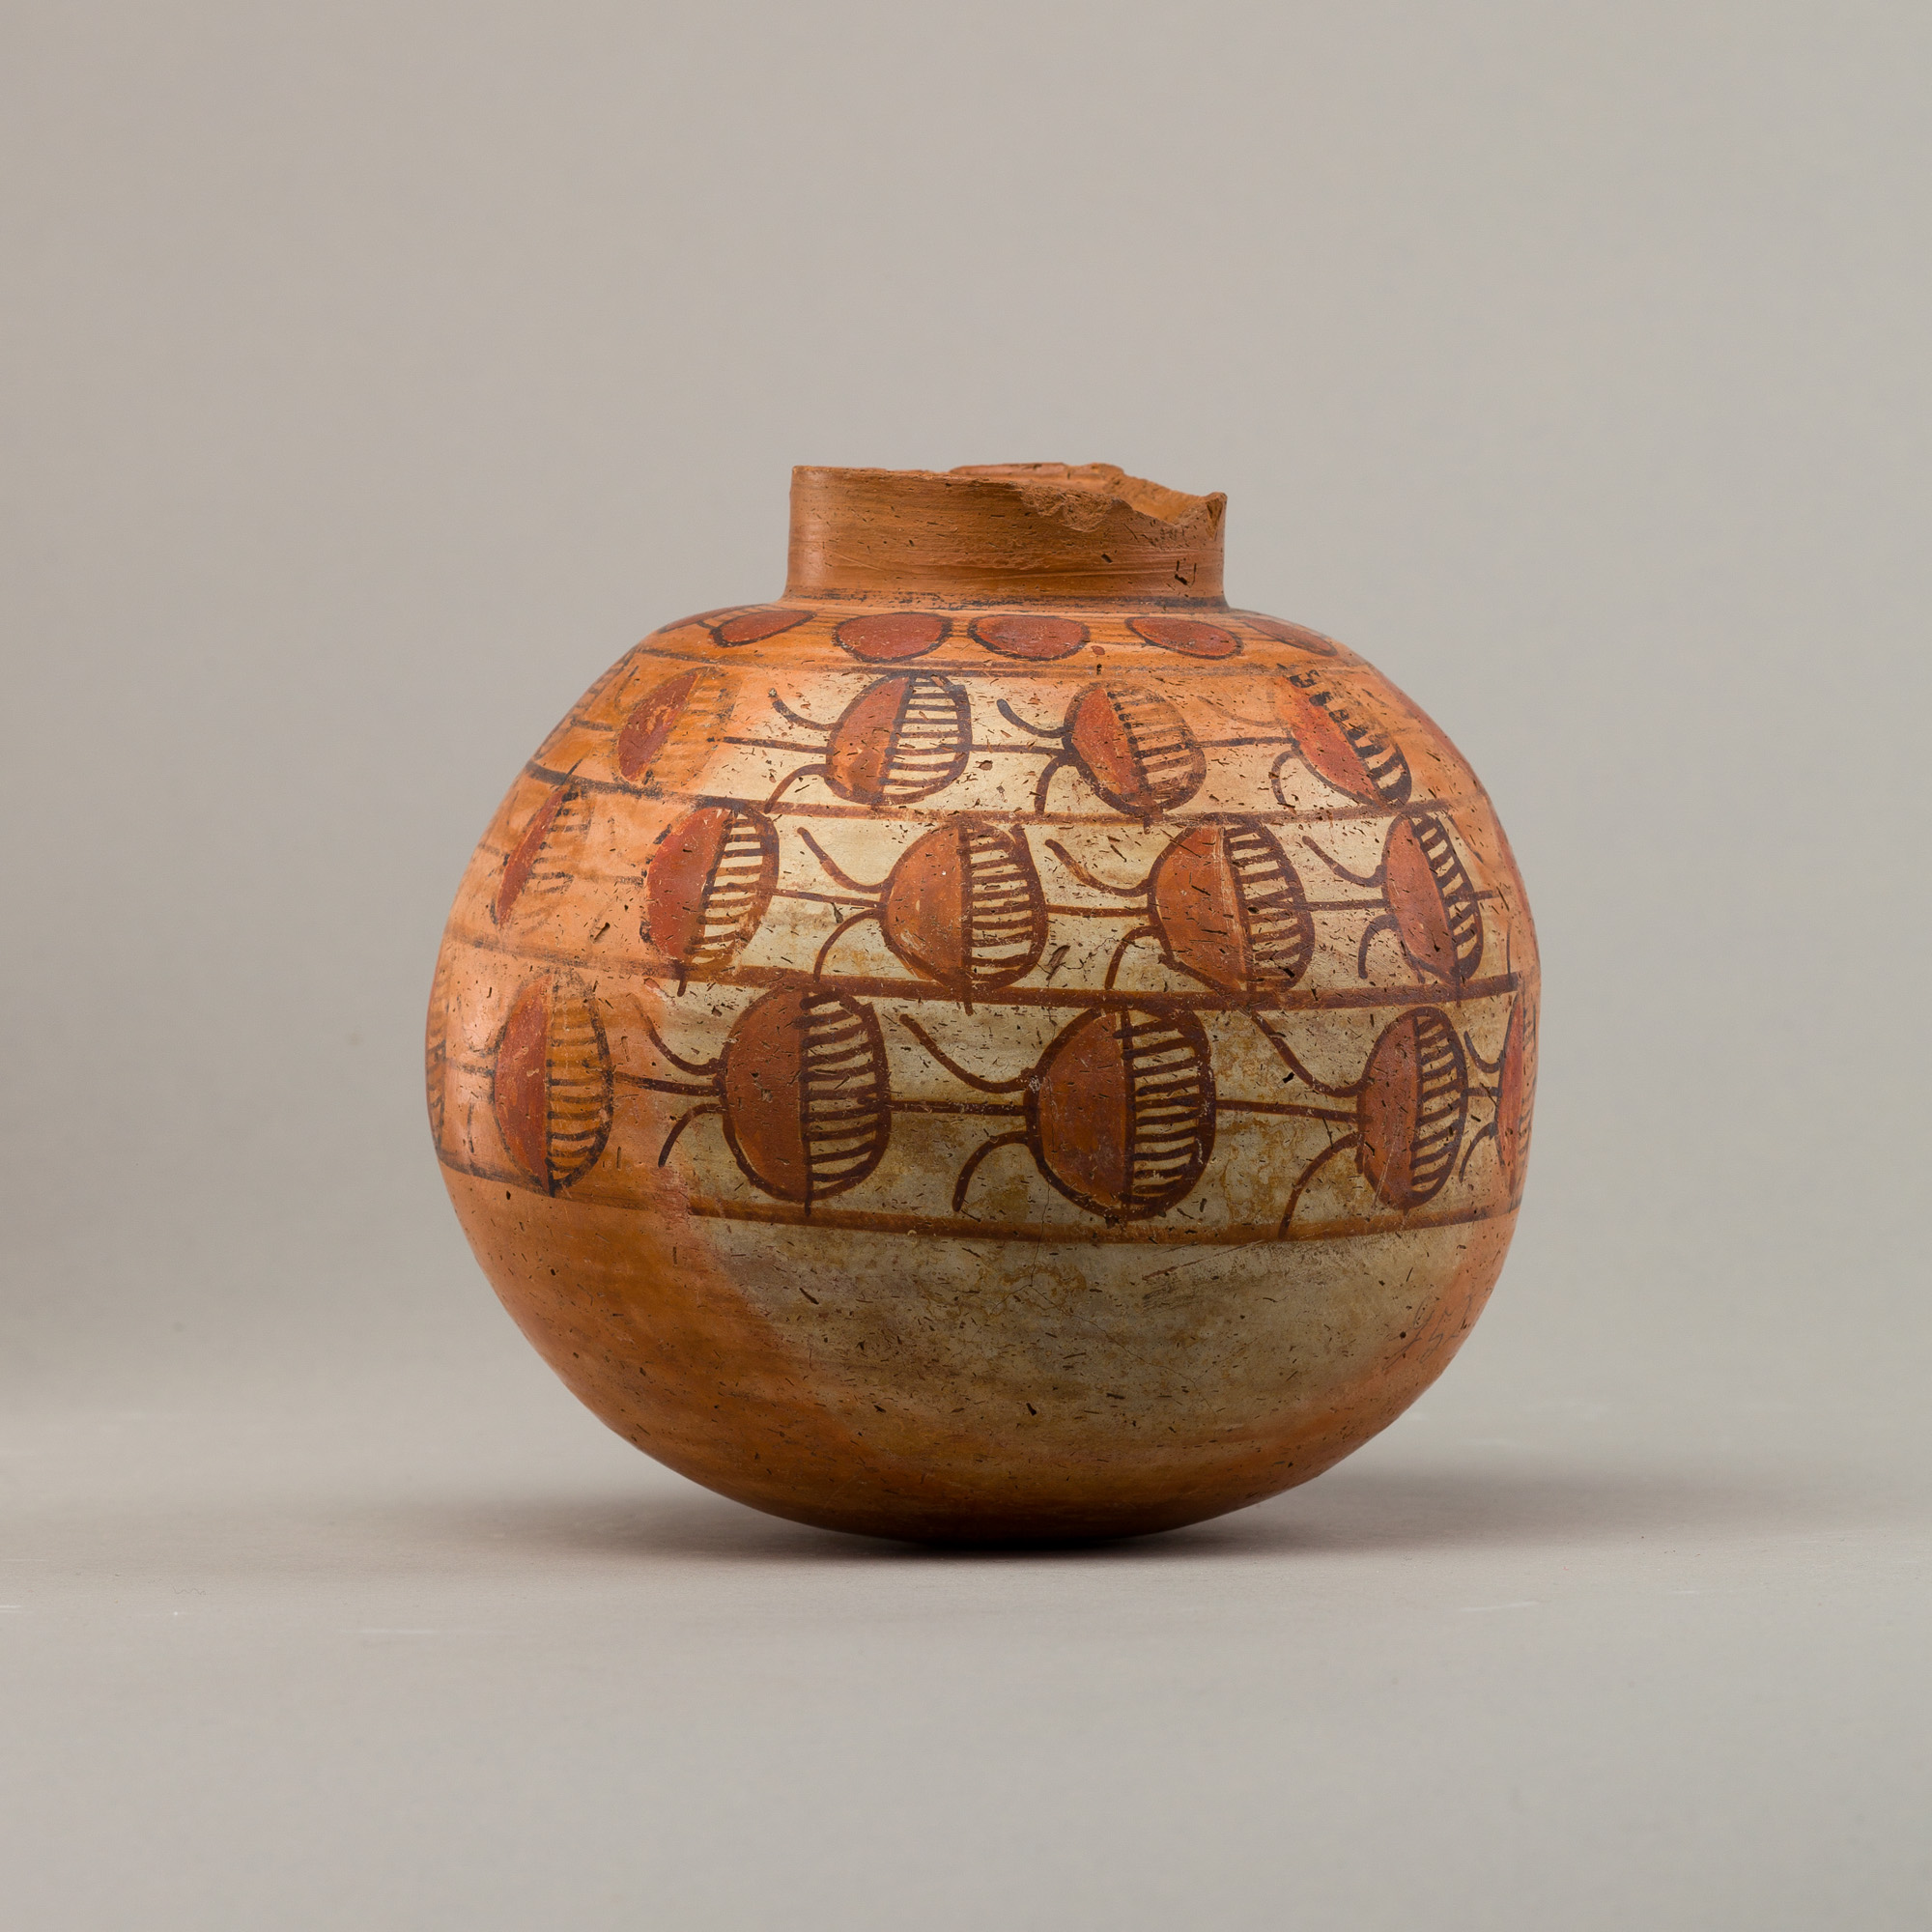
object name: jar, spherical, painted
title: Spherical jar with four rows of painted decoration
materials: paint, pottery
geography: egypt and sudan